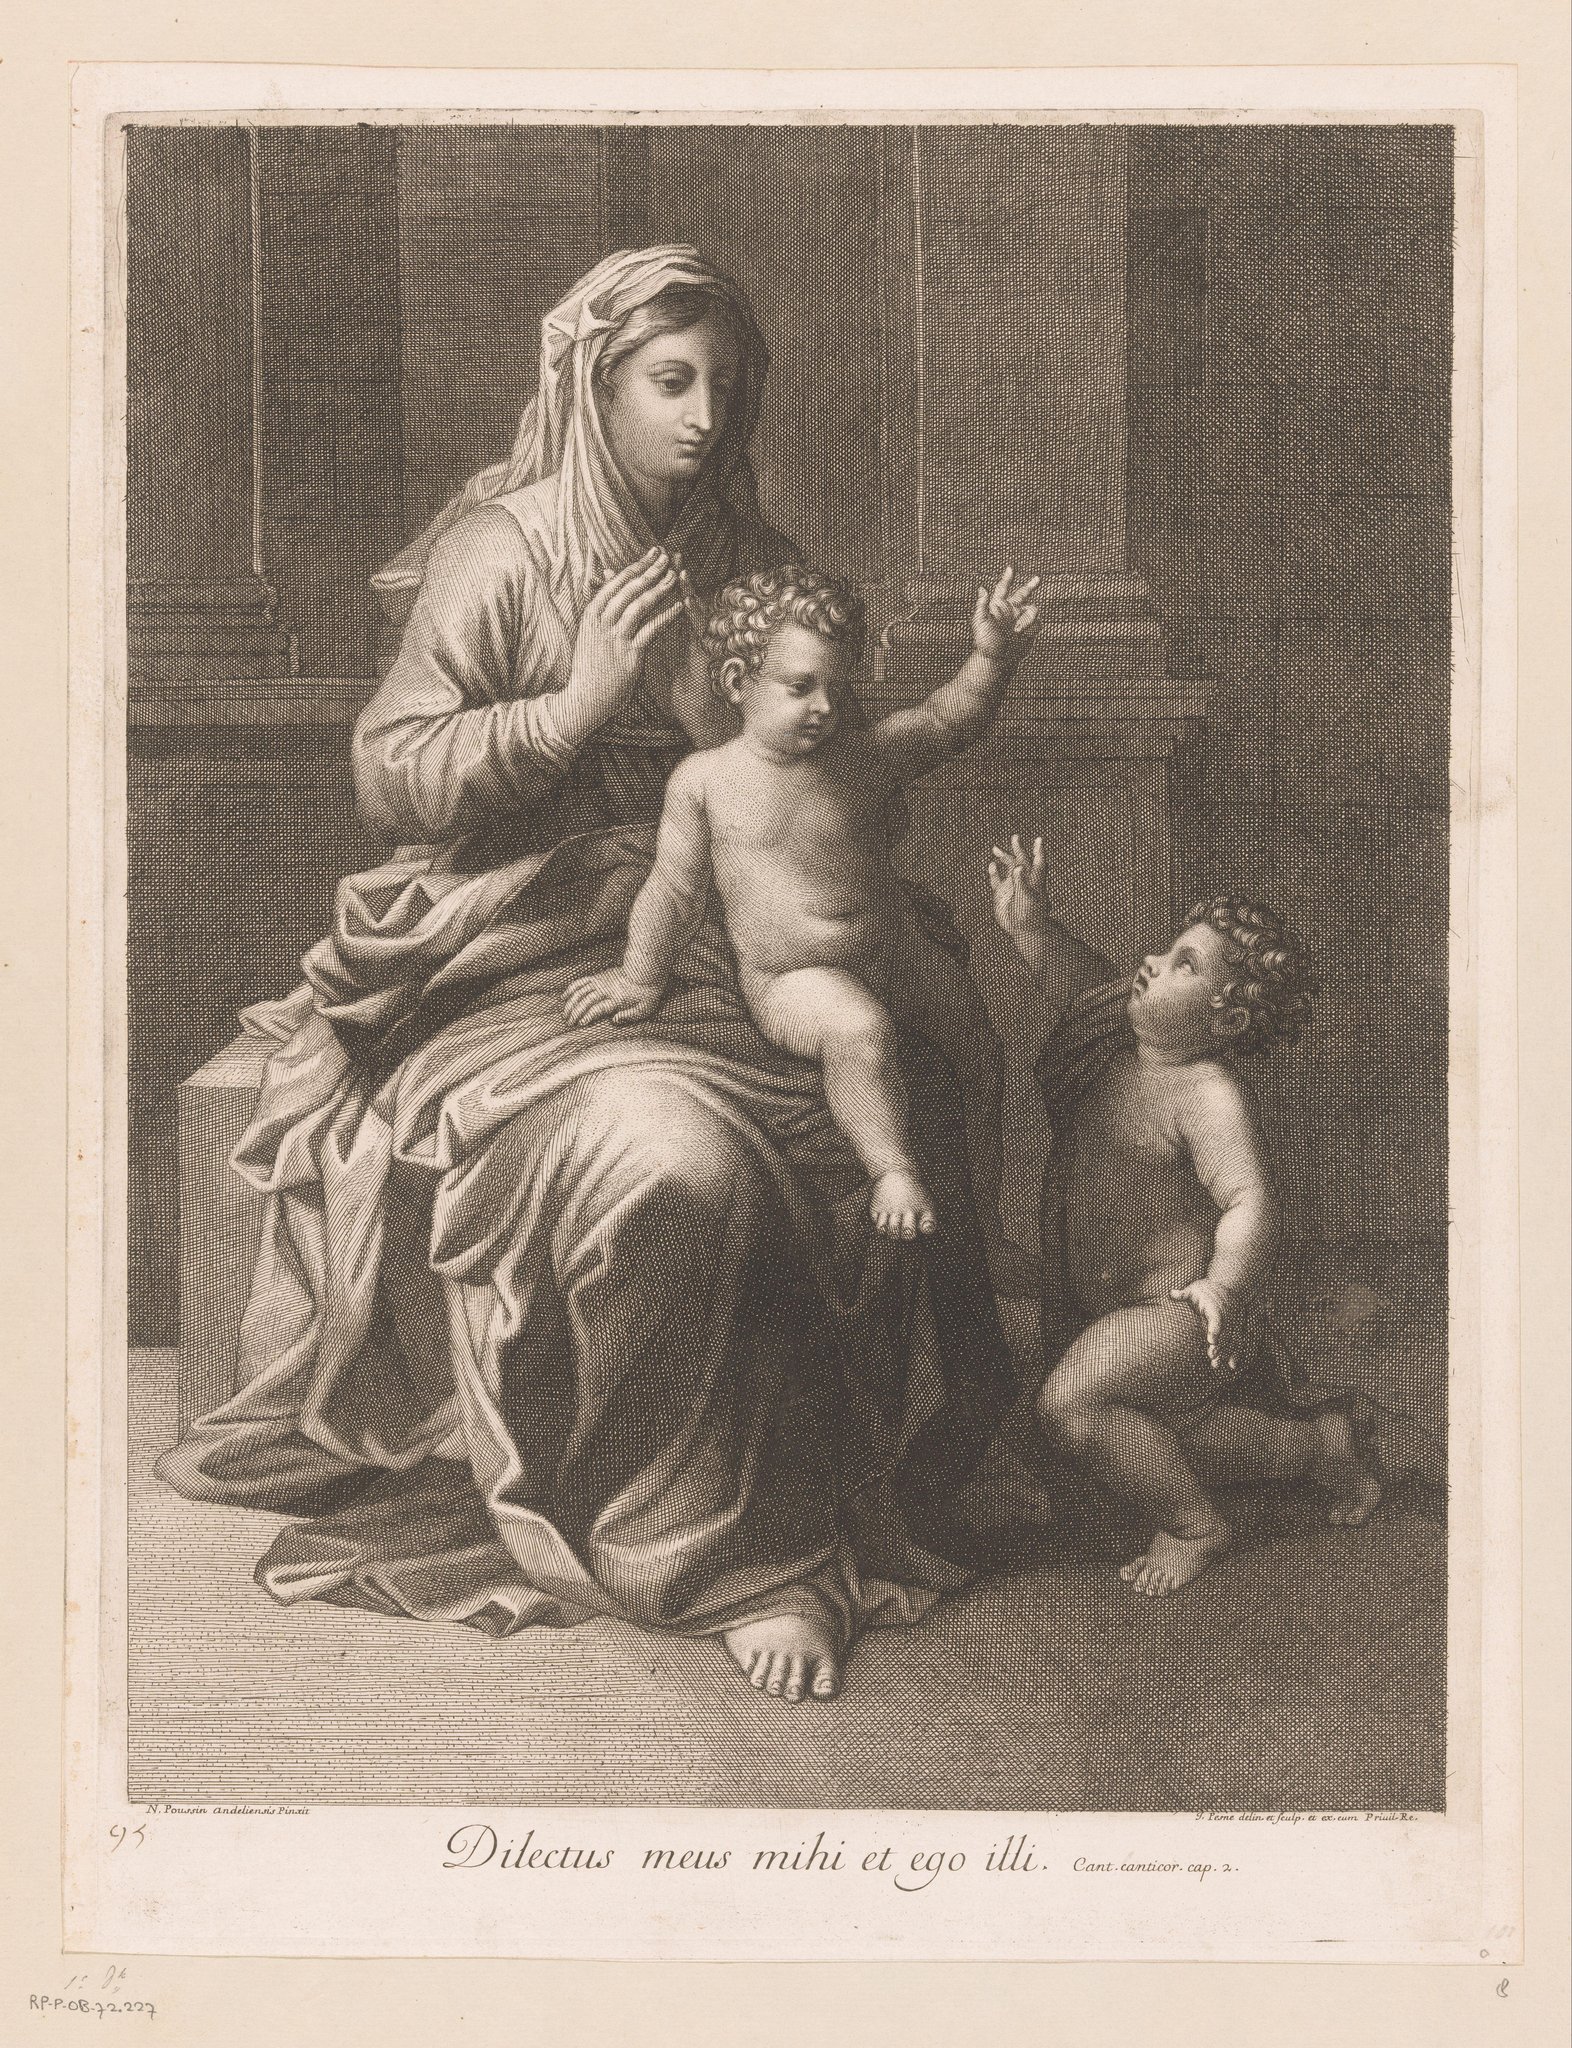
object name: print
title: Dilectus meus mihi et ego illi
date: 1633-1700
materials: paper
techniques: engraving, etching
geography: france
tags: madonna: mary sitting or enthroned, the christ-child in her lap (or in front of her bosom) (mary sometimes represented half-length), mary and the christ-child with john the baptist (as child)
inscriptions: collector's mark: Lugt 240